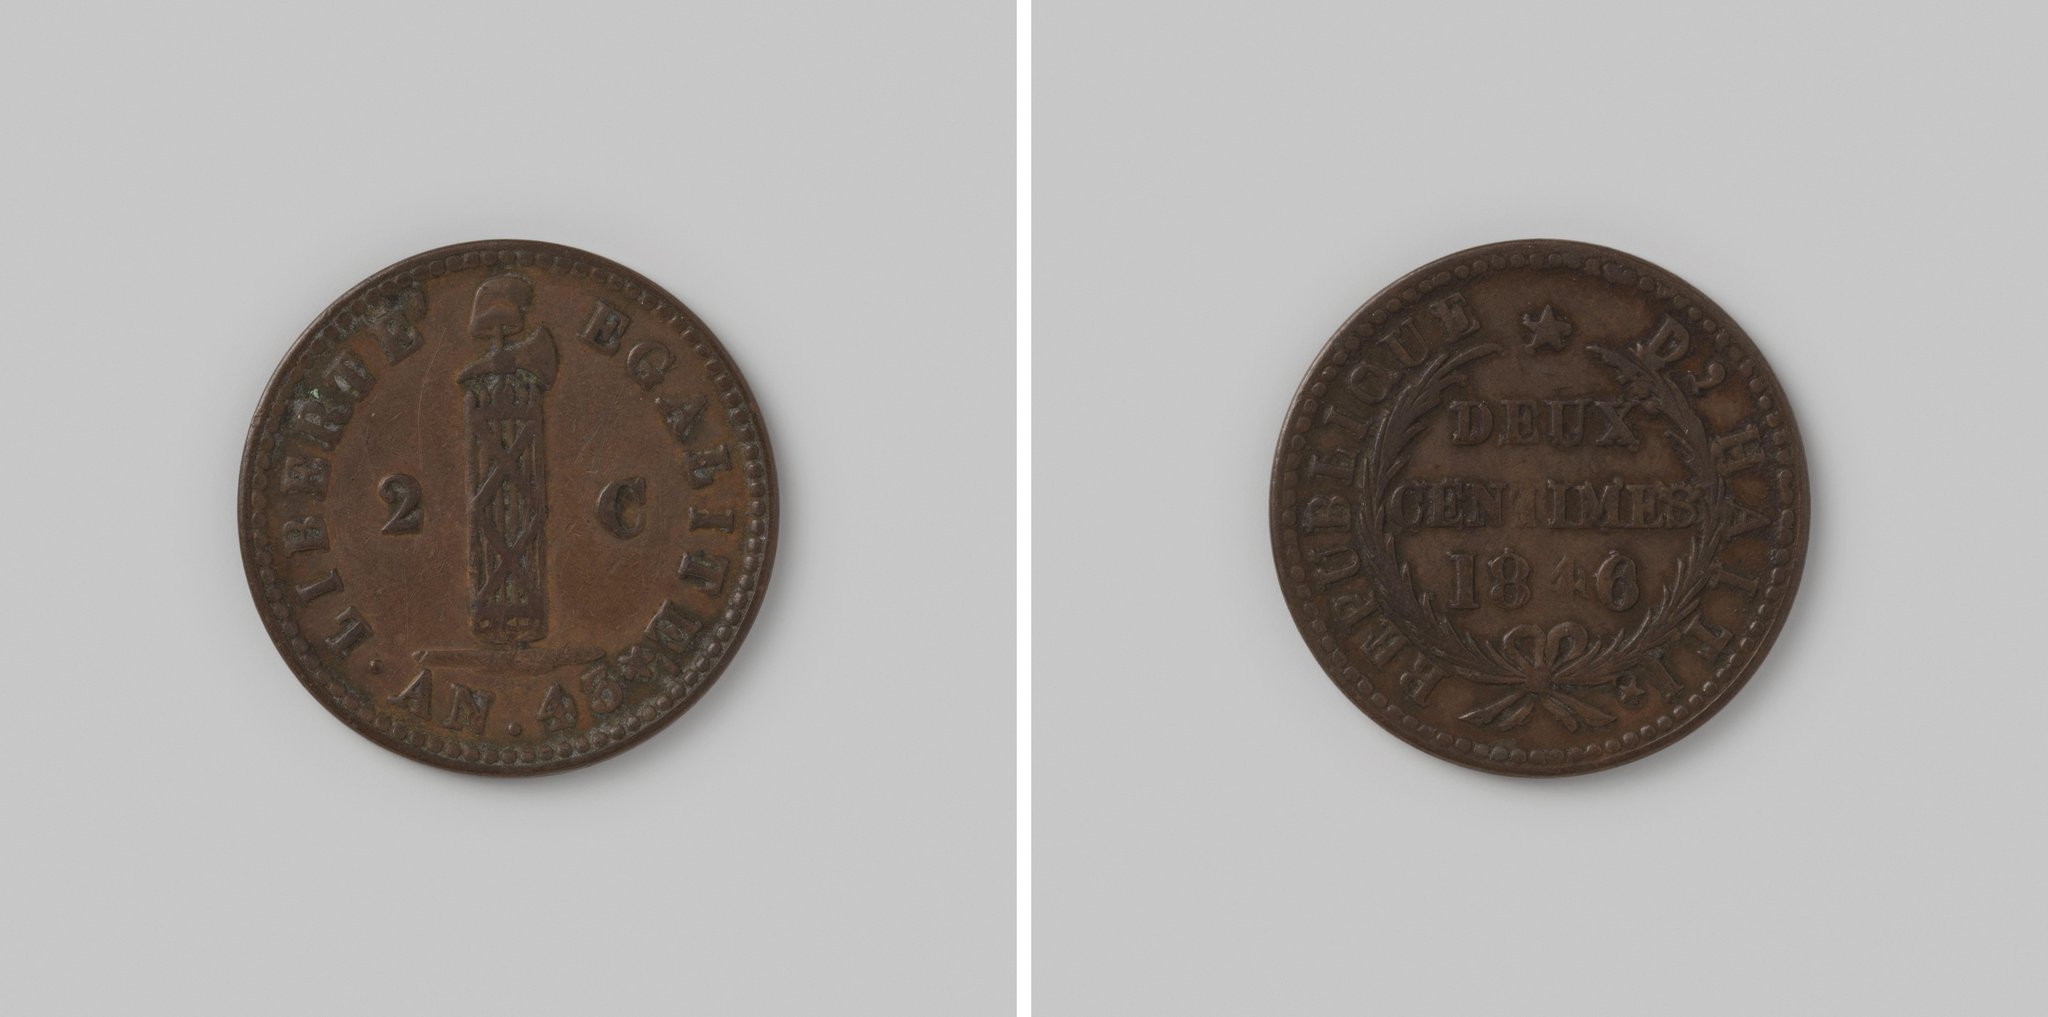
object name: twee centime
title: Haïti, Louis Pierrot, 2 centimes, 1846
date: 1846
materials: copper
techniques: striking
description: Koperen munt. Voorzijde: tussen waarde-aanduiding in grond geplante pijl, binnen pijlenbundel, waarop bijl en vrijheidshoed. Onderaan jaartal: AN 43. Keerzijde: tussen twee samengebonden takken ster, waaronder waarde-aanduiding in twee regels, daaronder jaartal. Gladde rand.